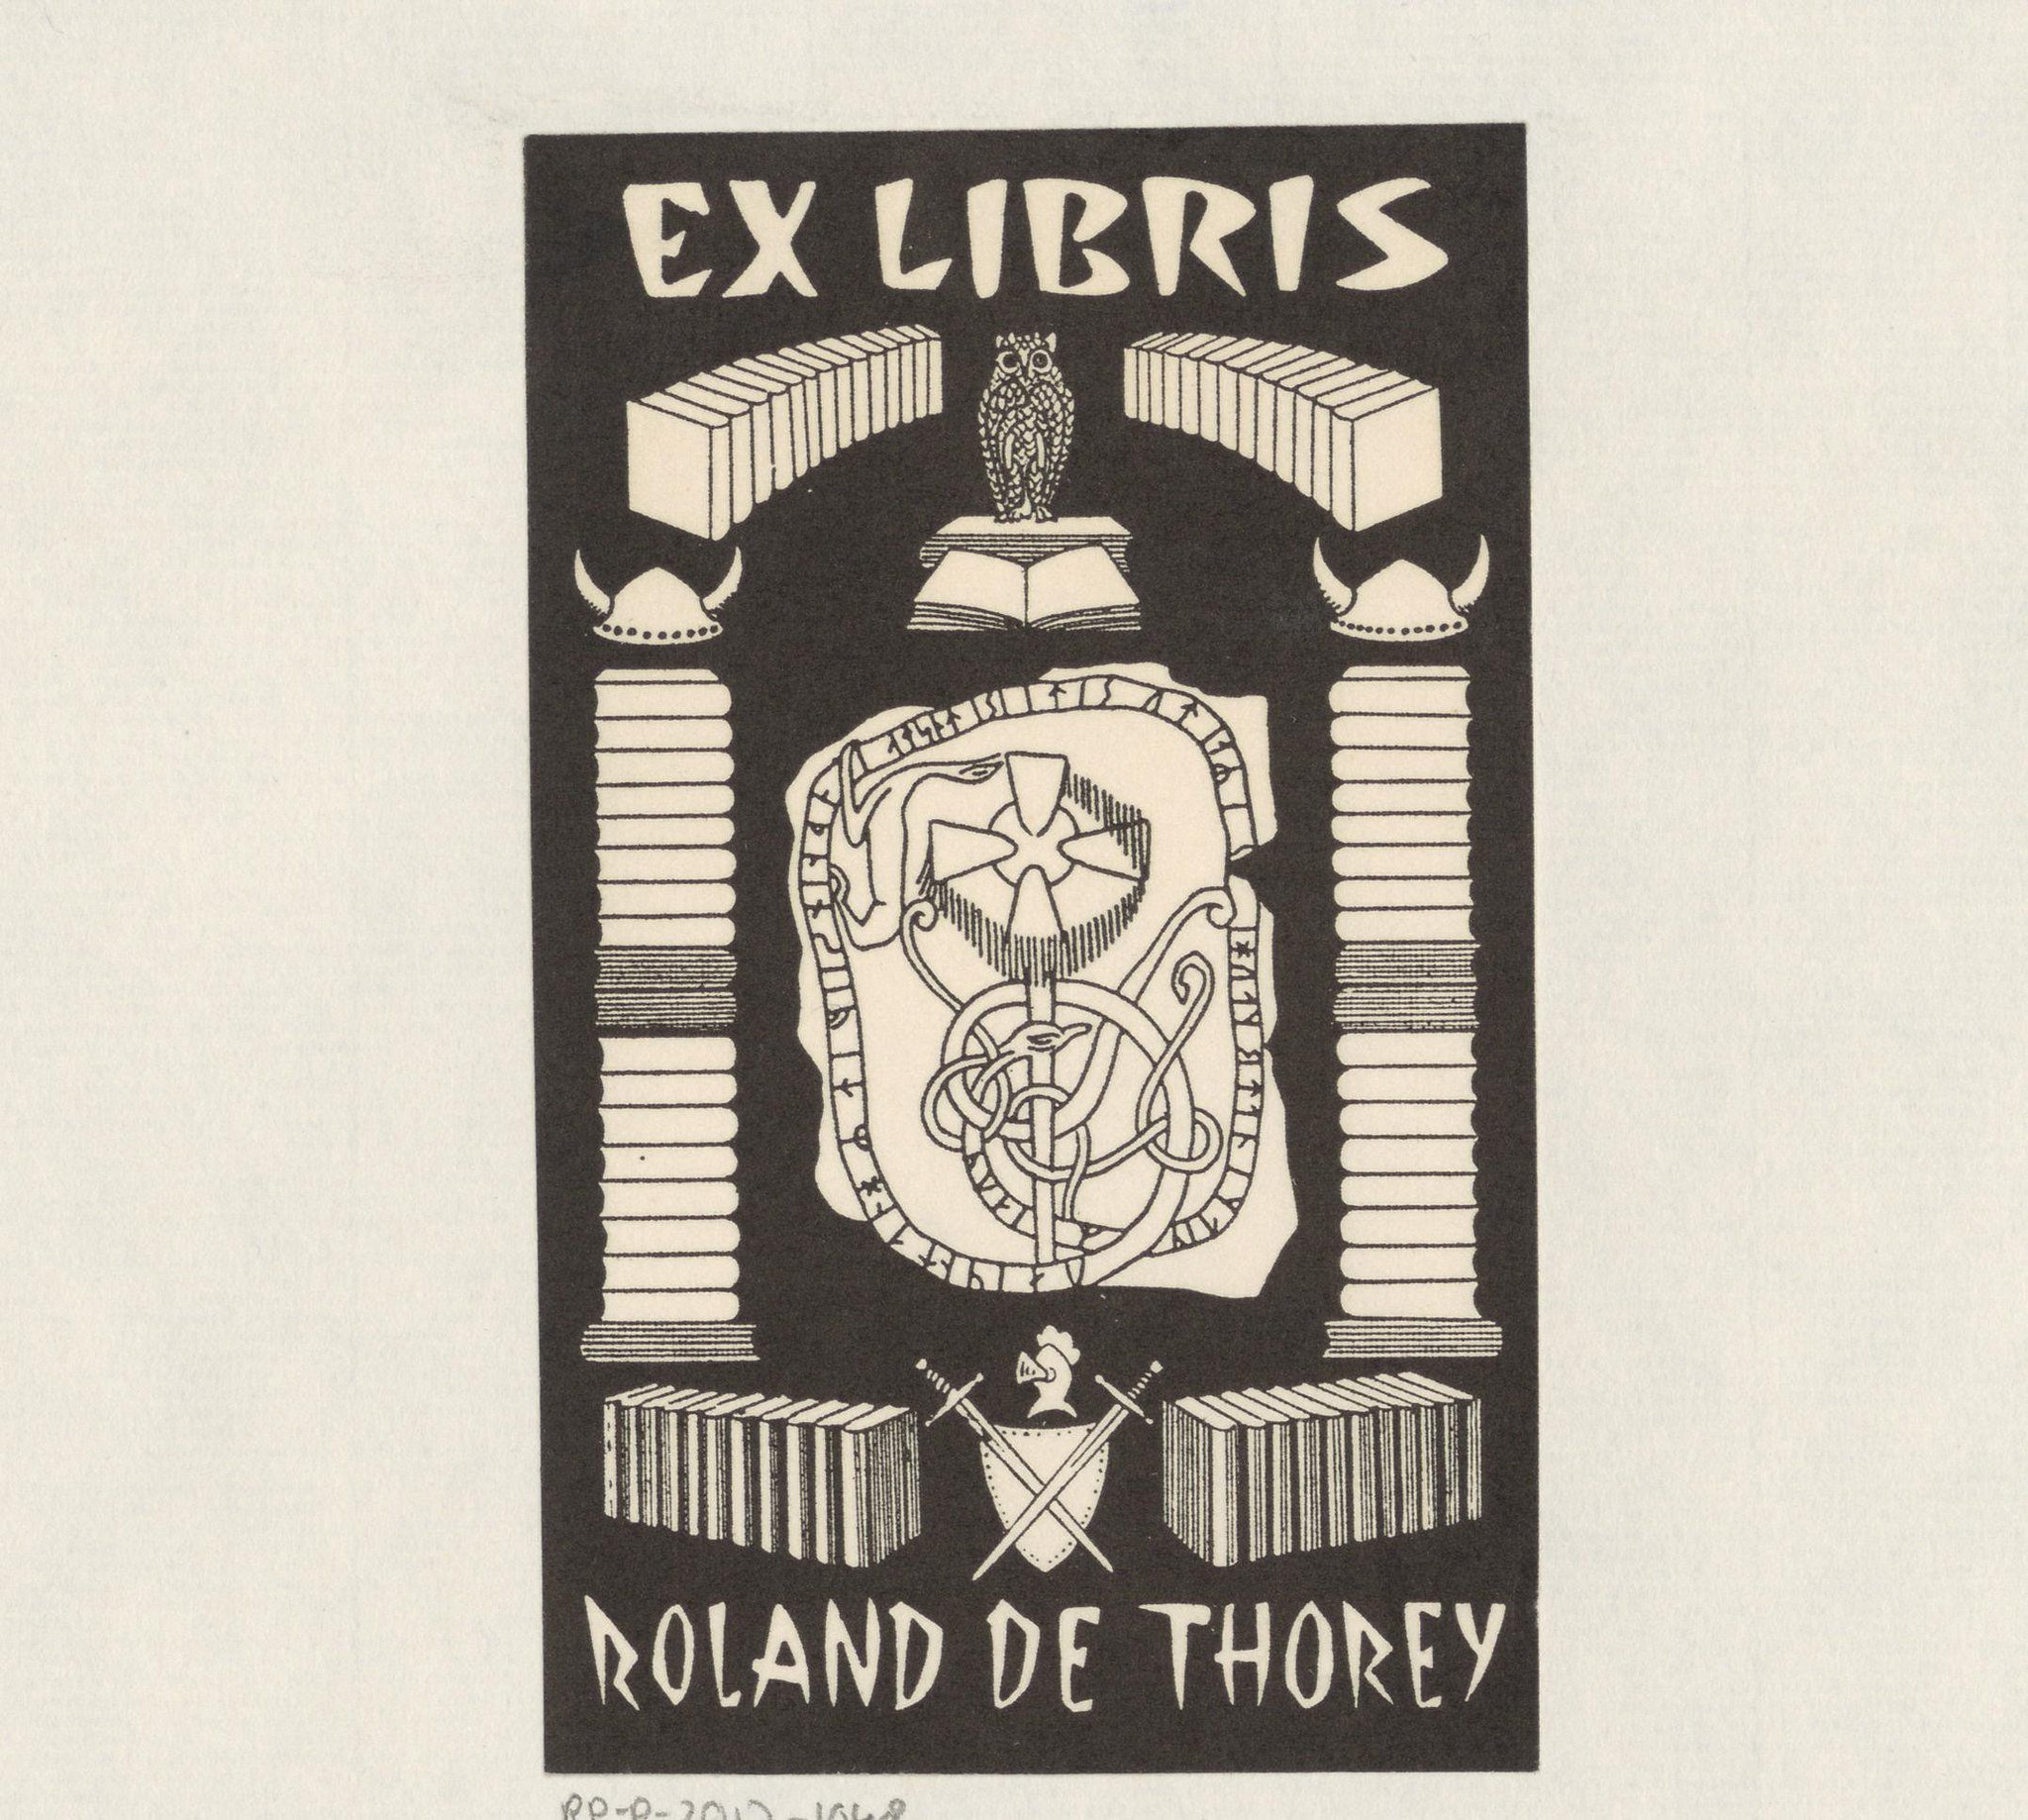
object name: bookplate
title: Ex libris van Roland de Thorey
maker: Anonymous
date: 1900-1999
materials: paper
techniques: printing block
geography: sweden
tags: helmet, book, extinct, 'historical' peoples (with name)